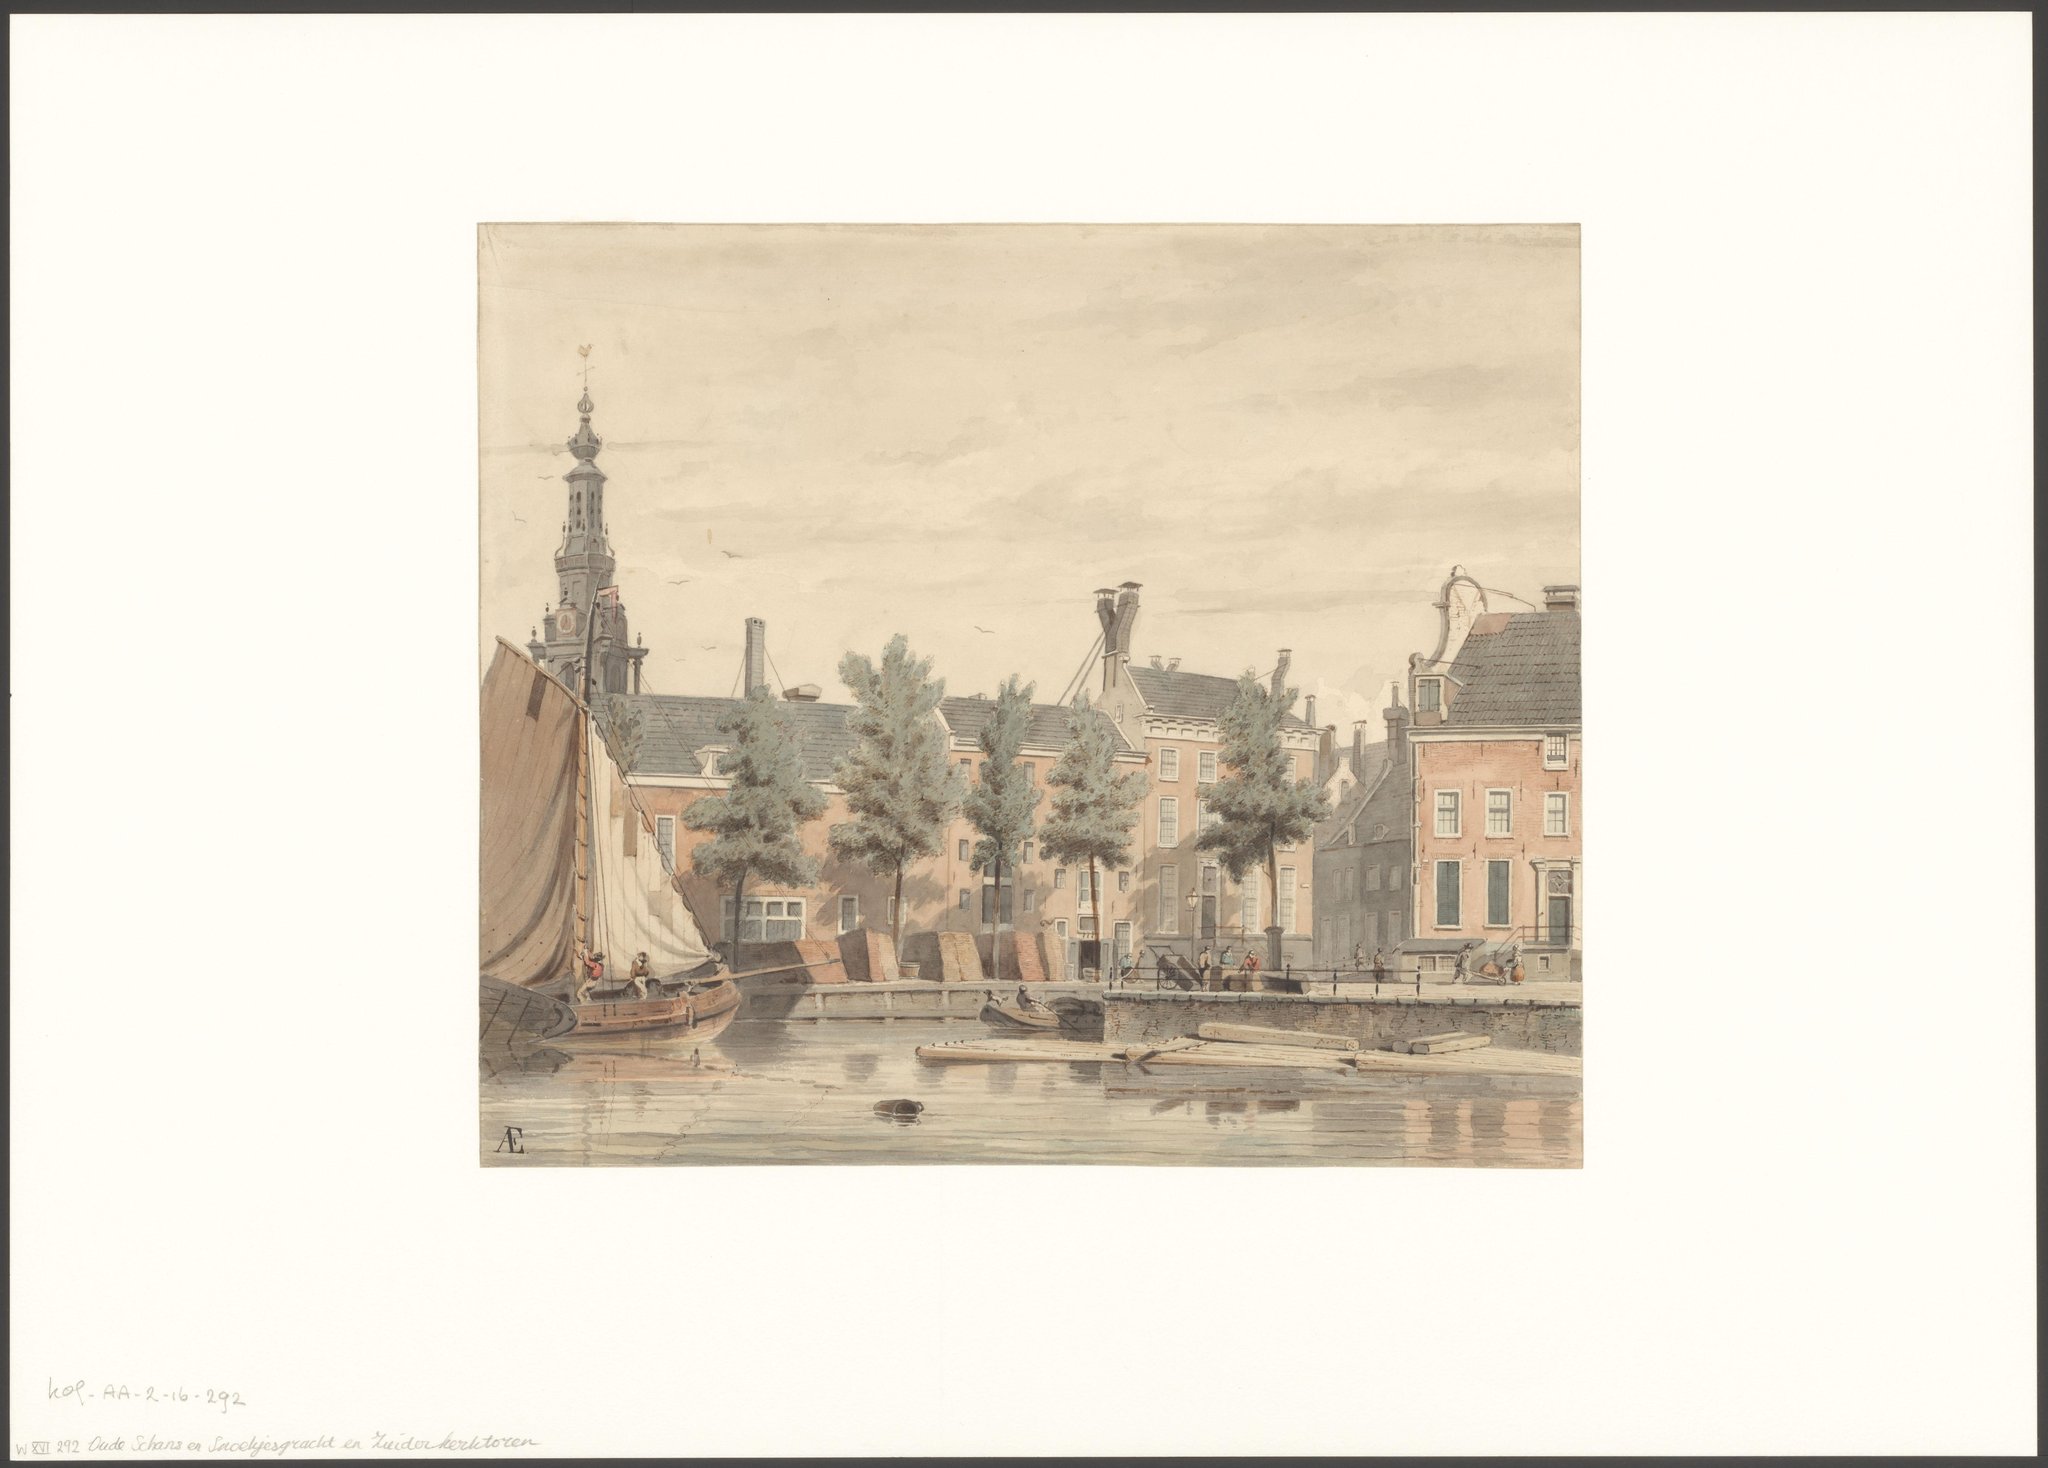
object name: drawing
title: Gezicht op de Oudeschans, de Snoekjessteeg en de Zuiderkerkstoren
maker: adrianus eversen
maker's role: draughtsman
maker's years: 1818-1897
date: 1855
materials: ink, paper, watercolor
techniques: brush, pen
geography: amsterdam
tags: sailing-ship, sailing-boat, city-view in general; 'veduta', canal, parts of church exterior and annexes: spire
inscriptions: signature and date: ‘AEversen ad viv. del. 55’, collector's mark: Lugt 800a, signature: ‘AE’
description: Tekening binnen de Atlas Van Eck ingedeeld op wijknummer 16.